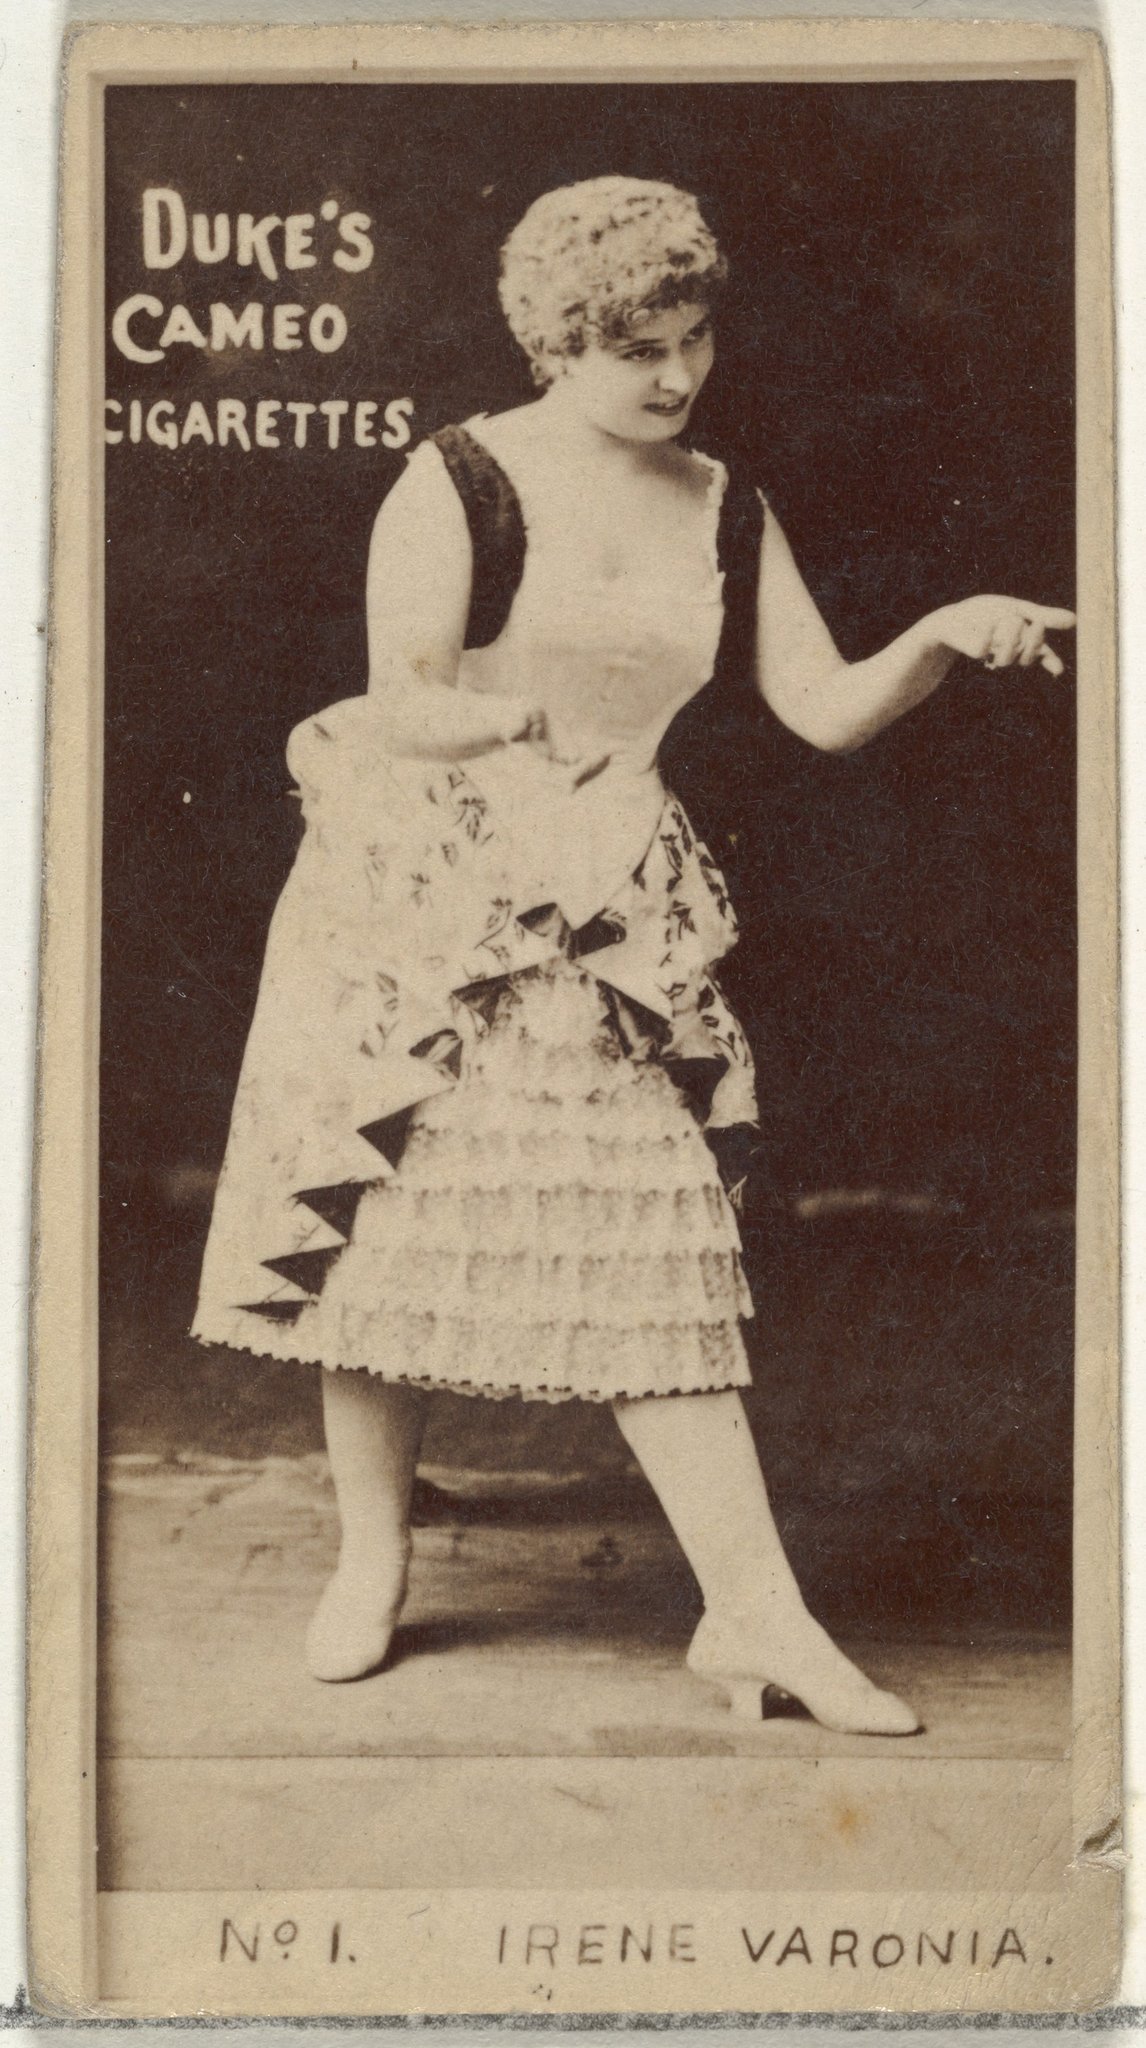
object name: photograph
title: Card Number 1, Irene Varonia, from the Actors and Actresses series (N145-4) issued by Duke Sons & Co. to promote Cameo Cigarettes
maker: w. duke, sons & co.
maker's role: publisher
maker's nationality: american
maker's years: 1870-1920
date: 1880-1889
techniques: albumen silver print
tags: portraits,women,actresses